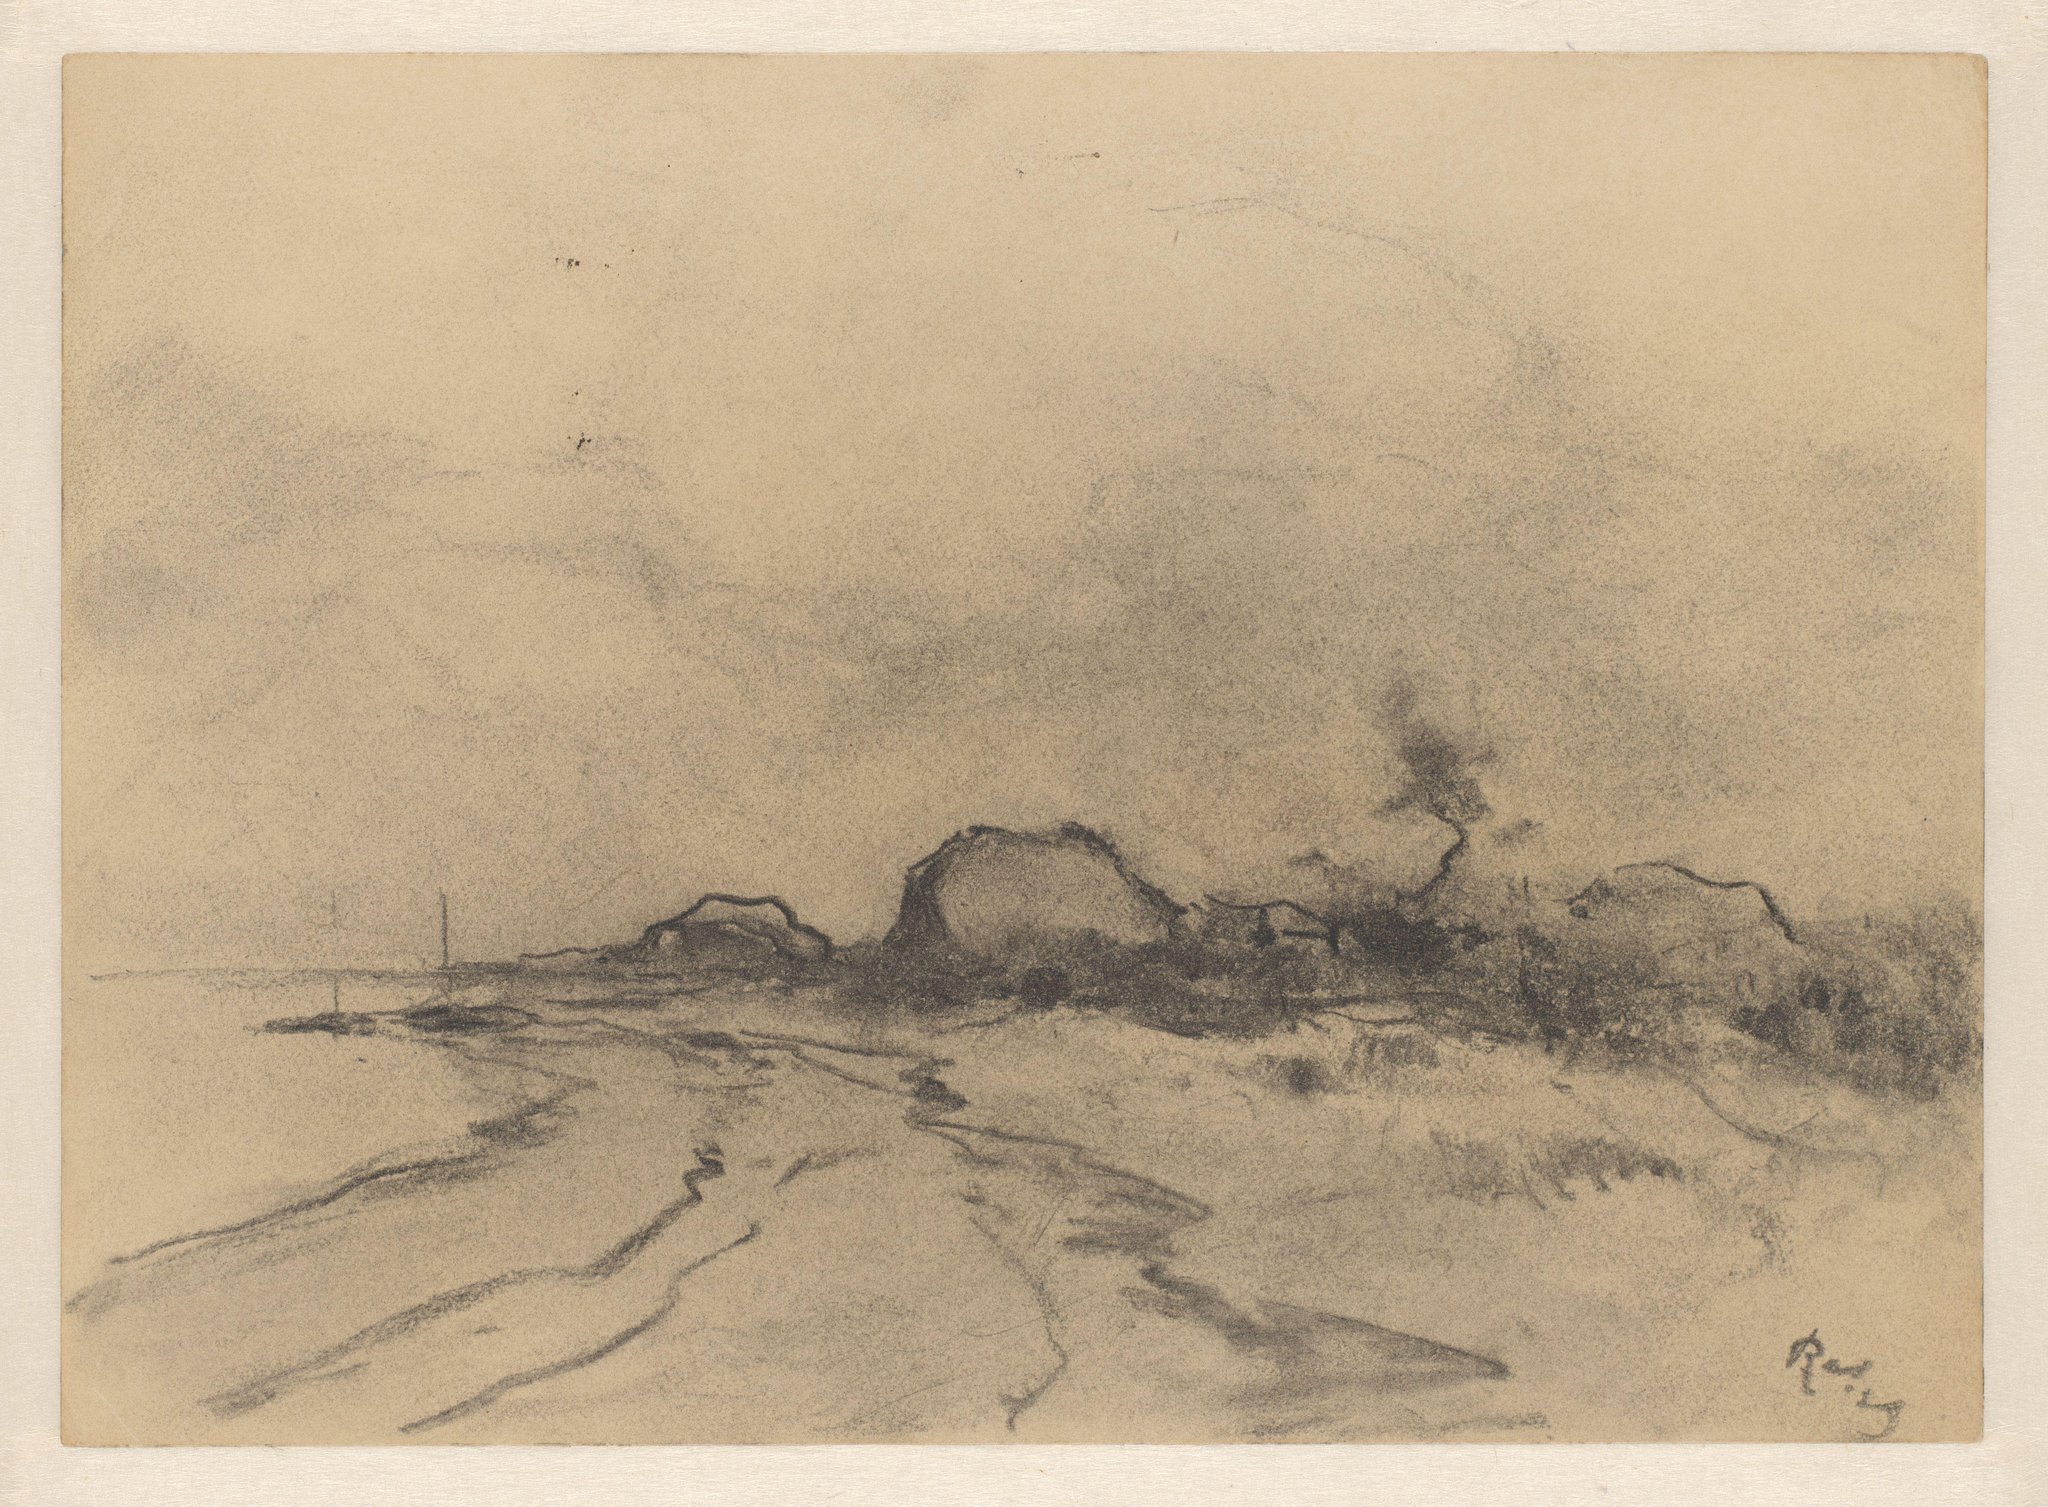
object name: drawing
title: Woningen bij een rivier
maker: pieter h.j.j. ras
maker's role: draughtsman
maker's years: 1857-1941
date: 1929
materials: chalk, paper